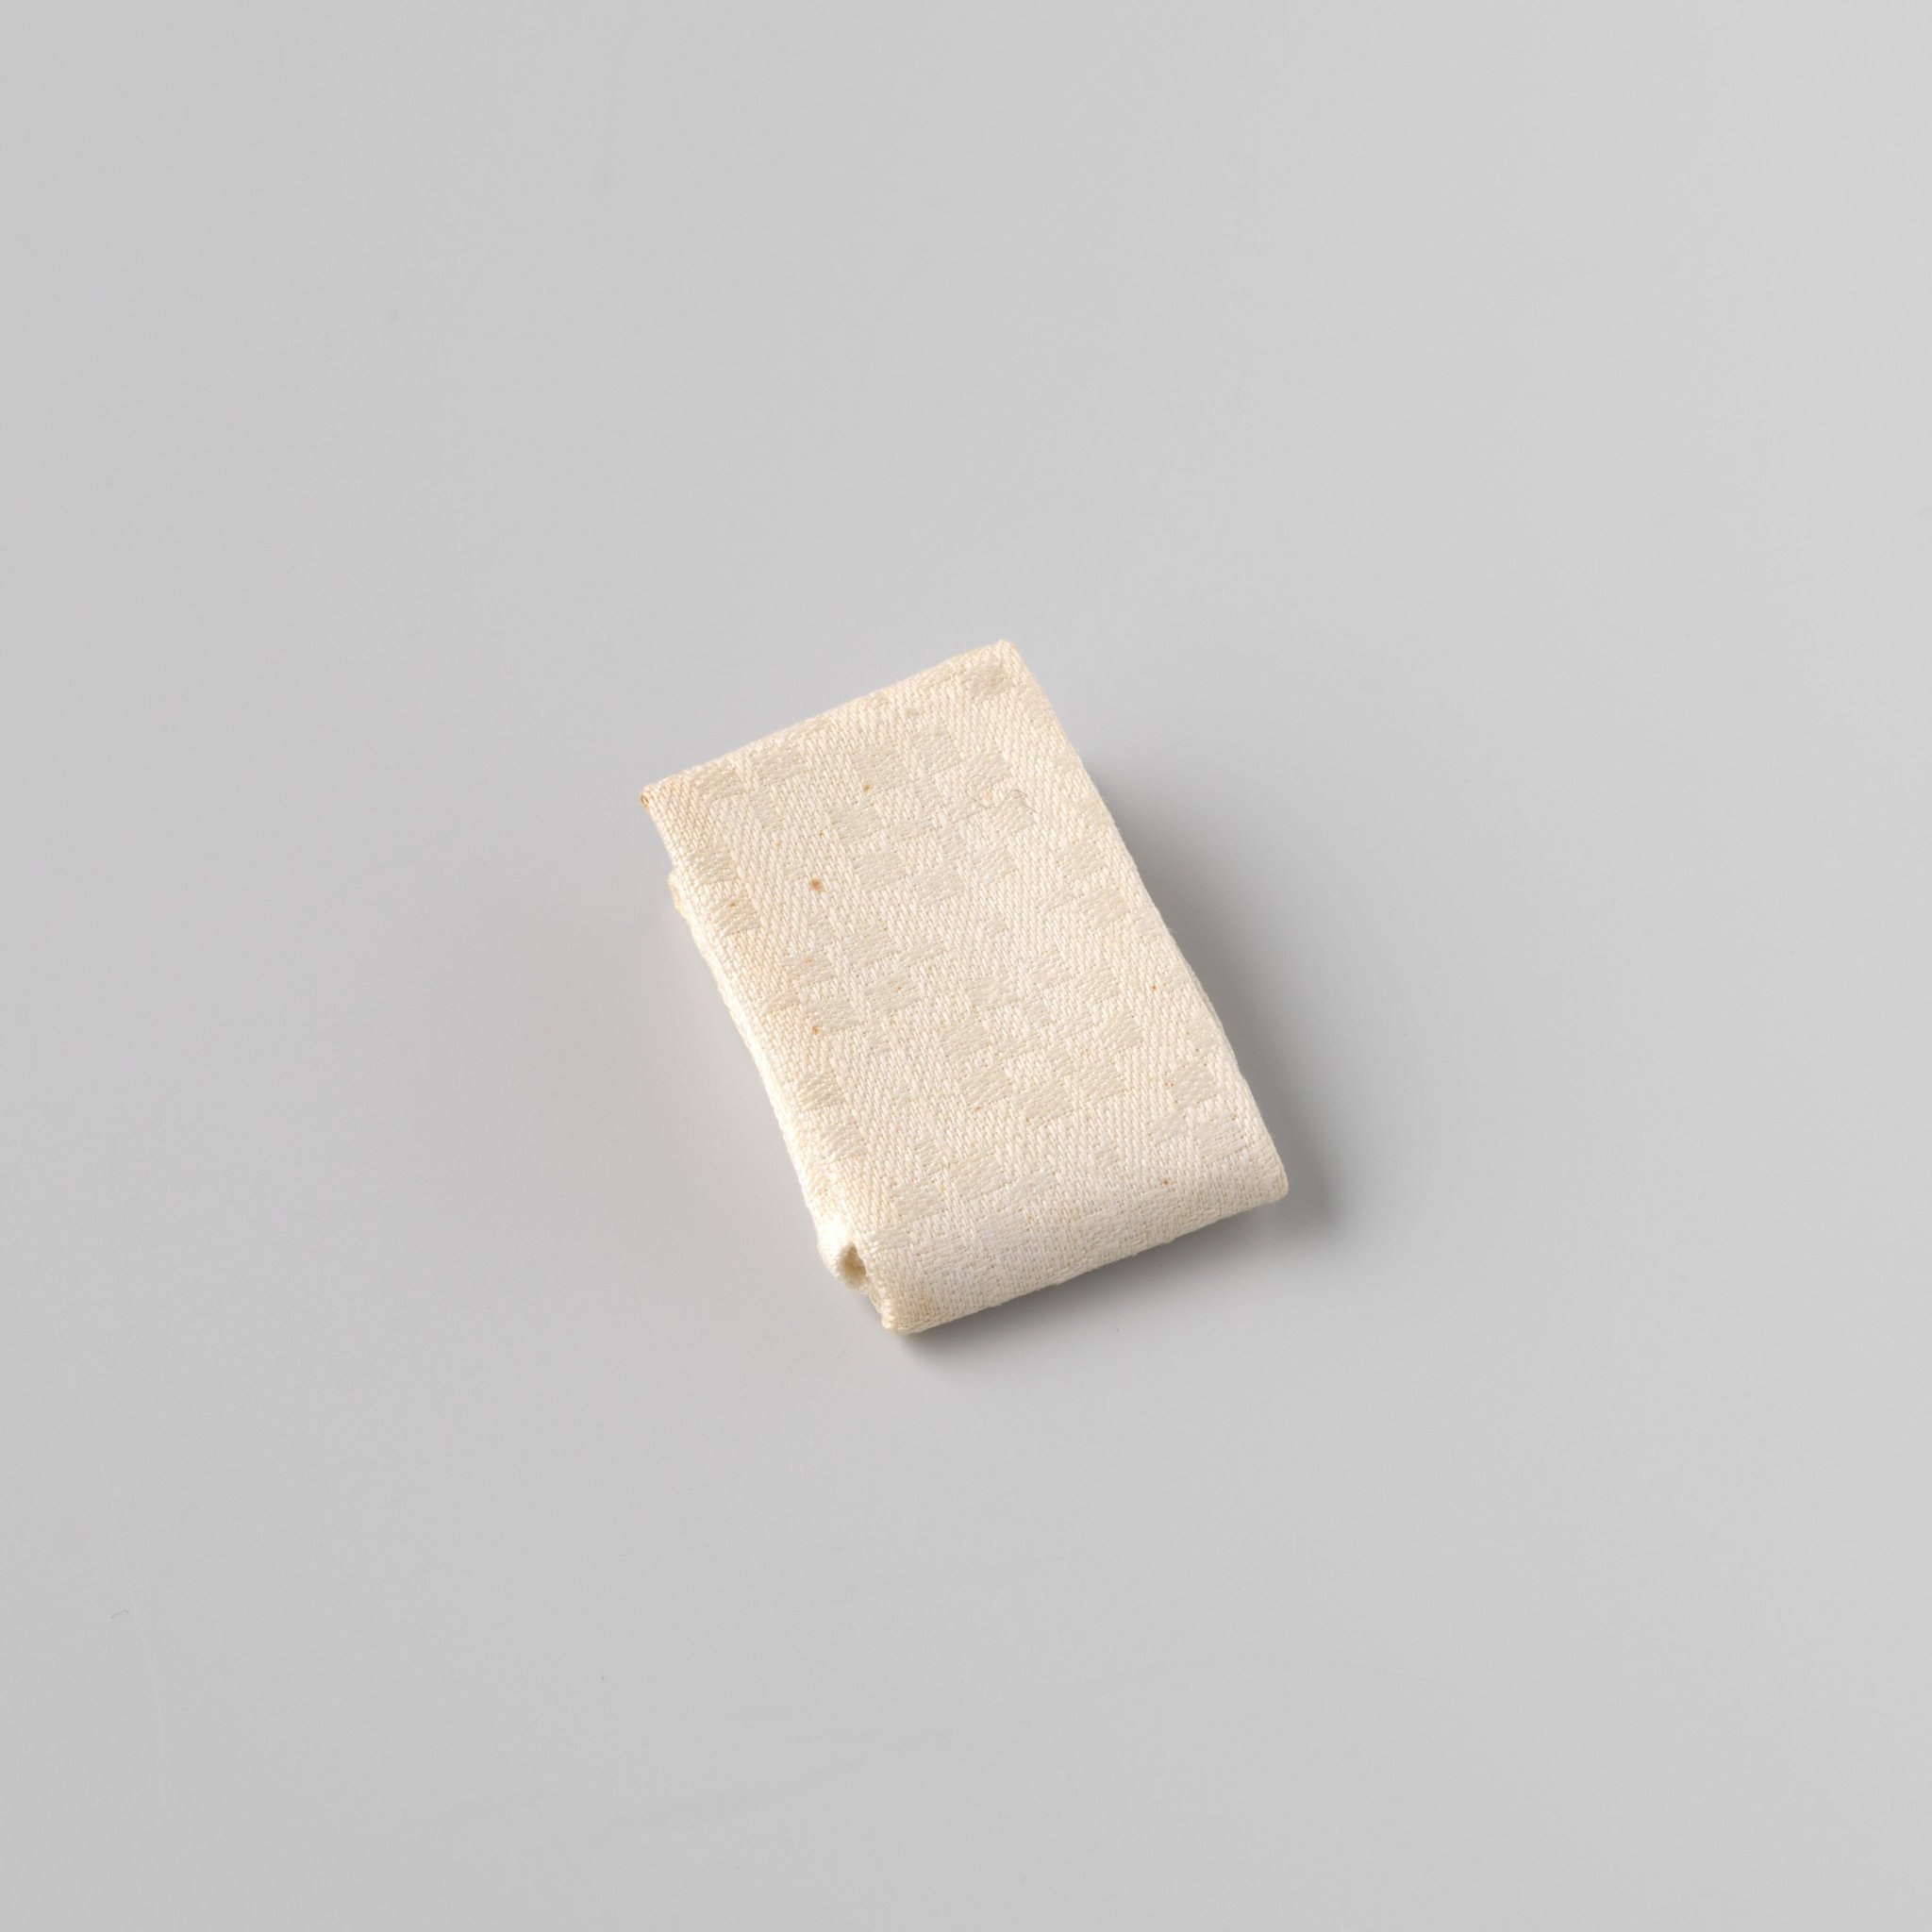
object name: miniature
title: Linnen servet van damastweefsel met pellenpatroon (motief II), aan vier zijden omzoomd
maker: Anonymous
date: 1690-1710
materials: linen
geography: haarlem